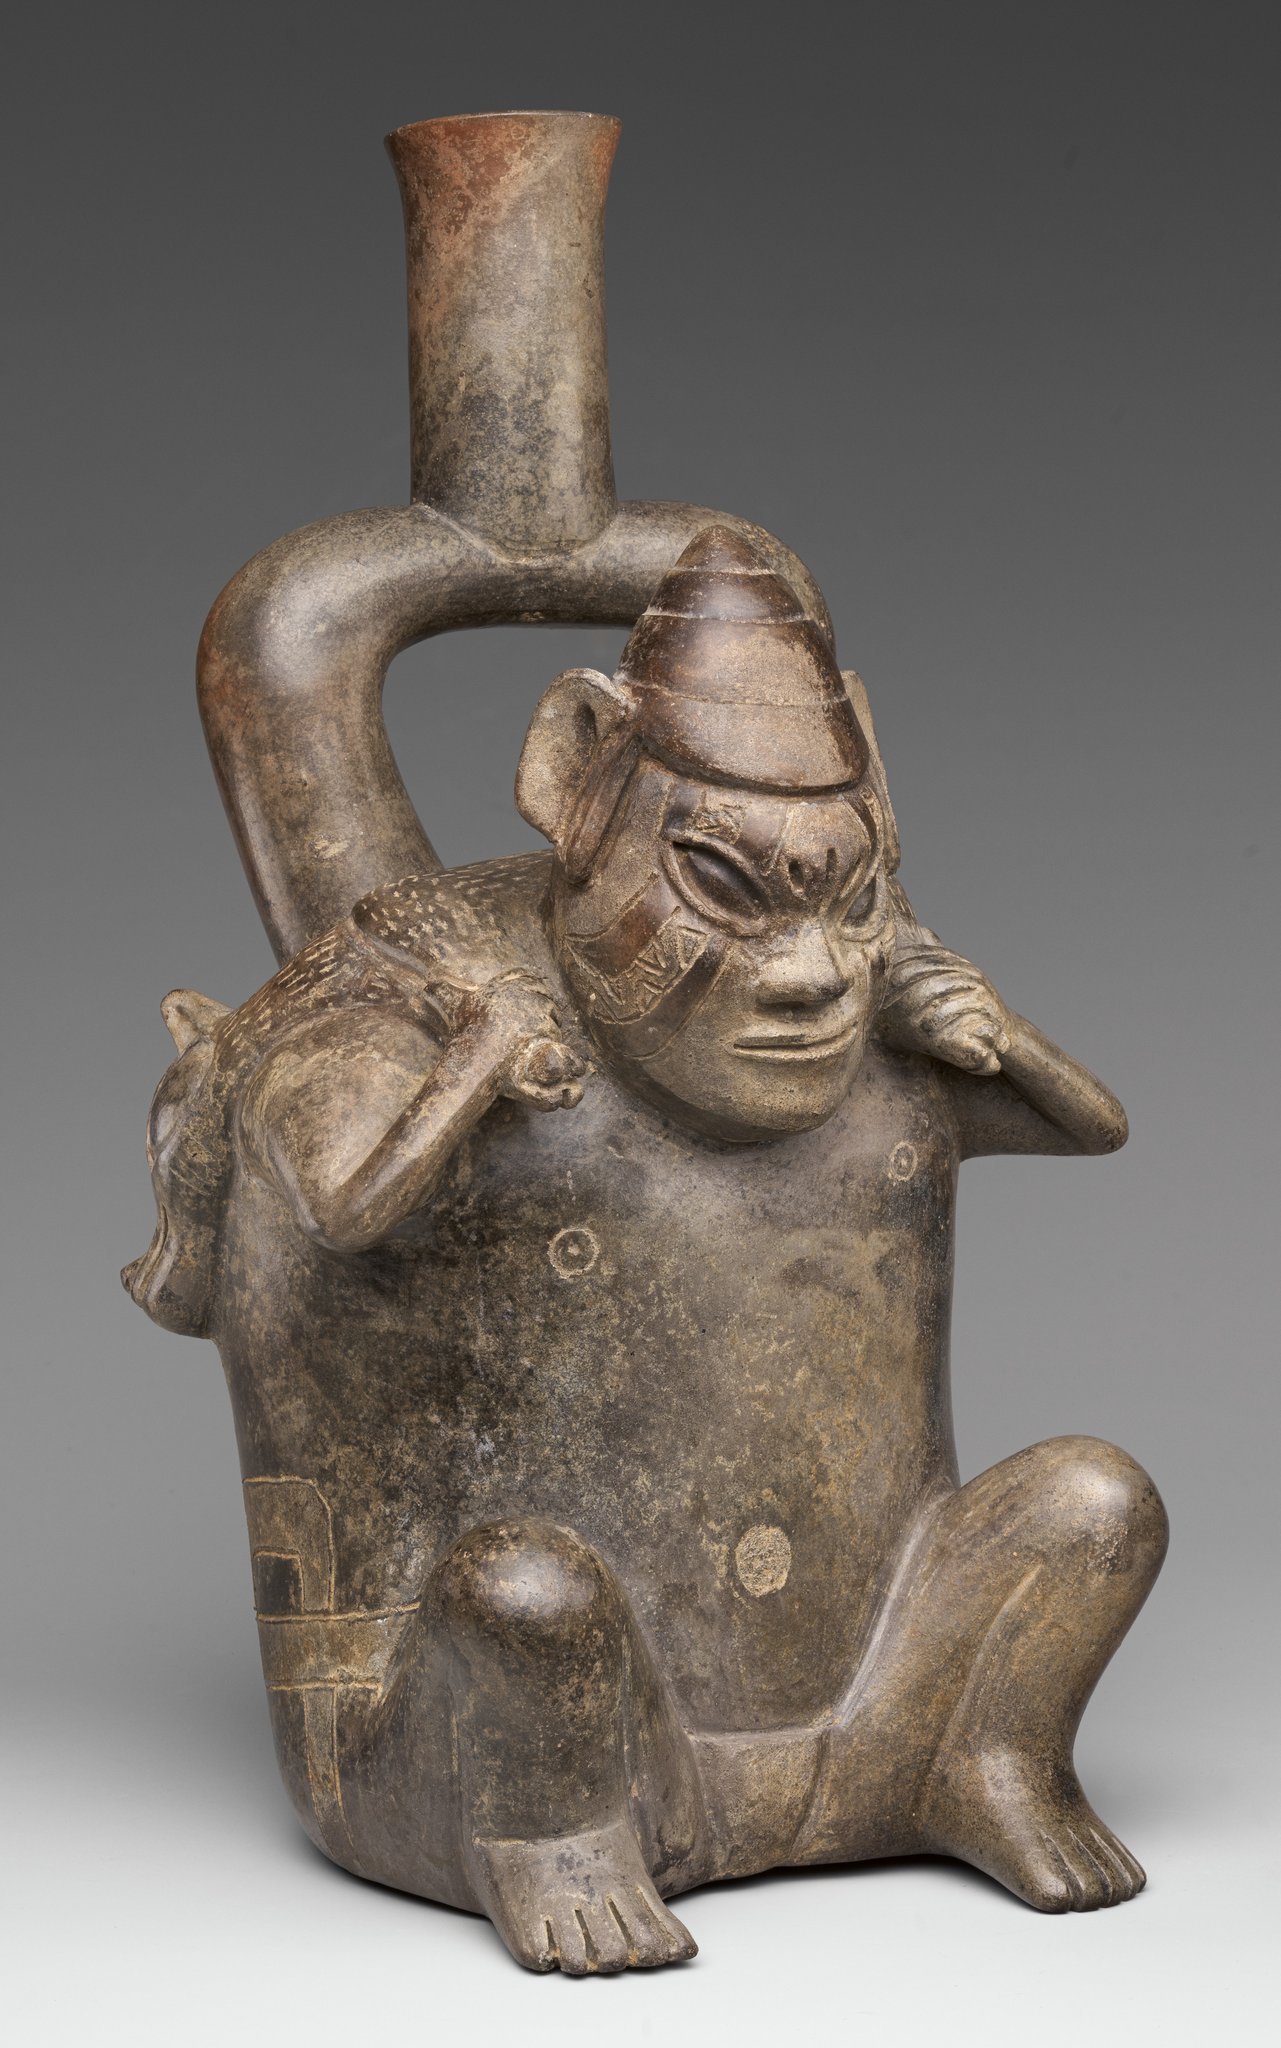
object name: bottle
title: Stirrup-spout bottle with figure carrying deer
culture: cupisnique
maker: cupisnique artist(s)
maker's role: artist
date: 1200-800 BCE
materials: ceramic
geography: peru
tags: men,deer